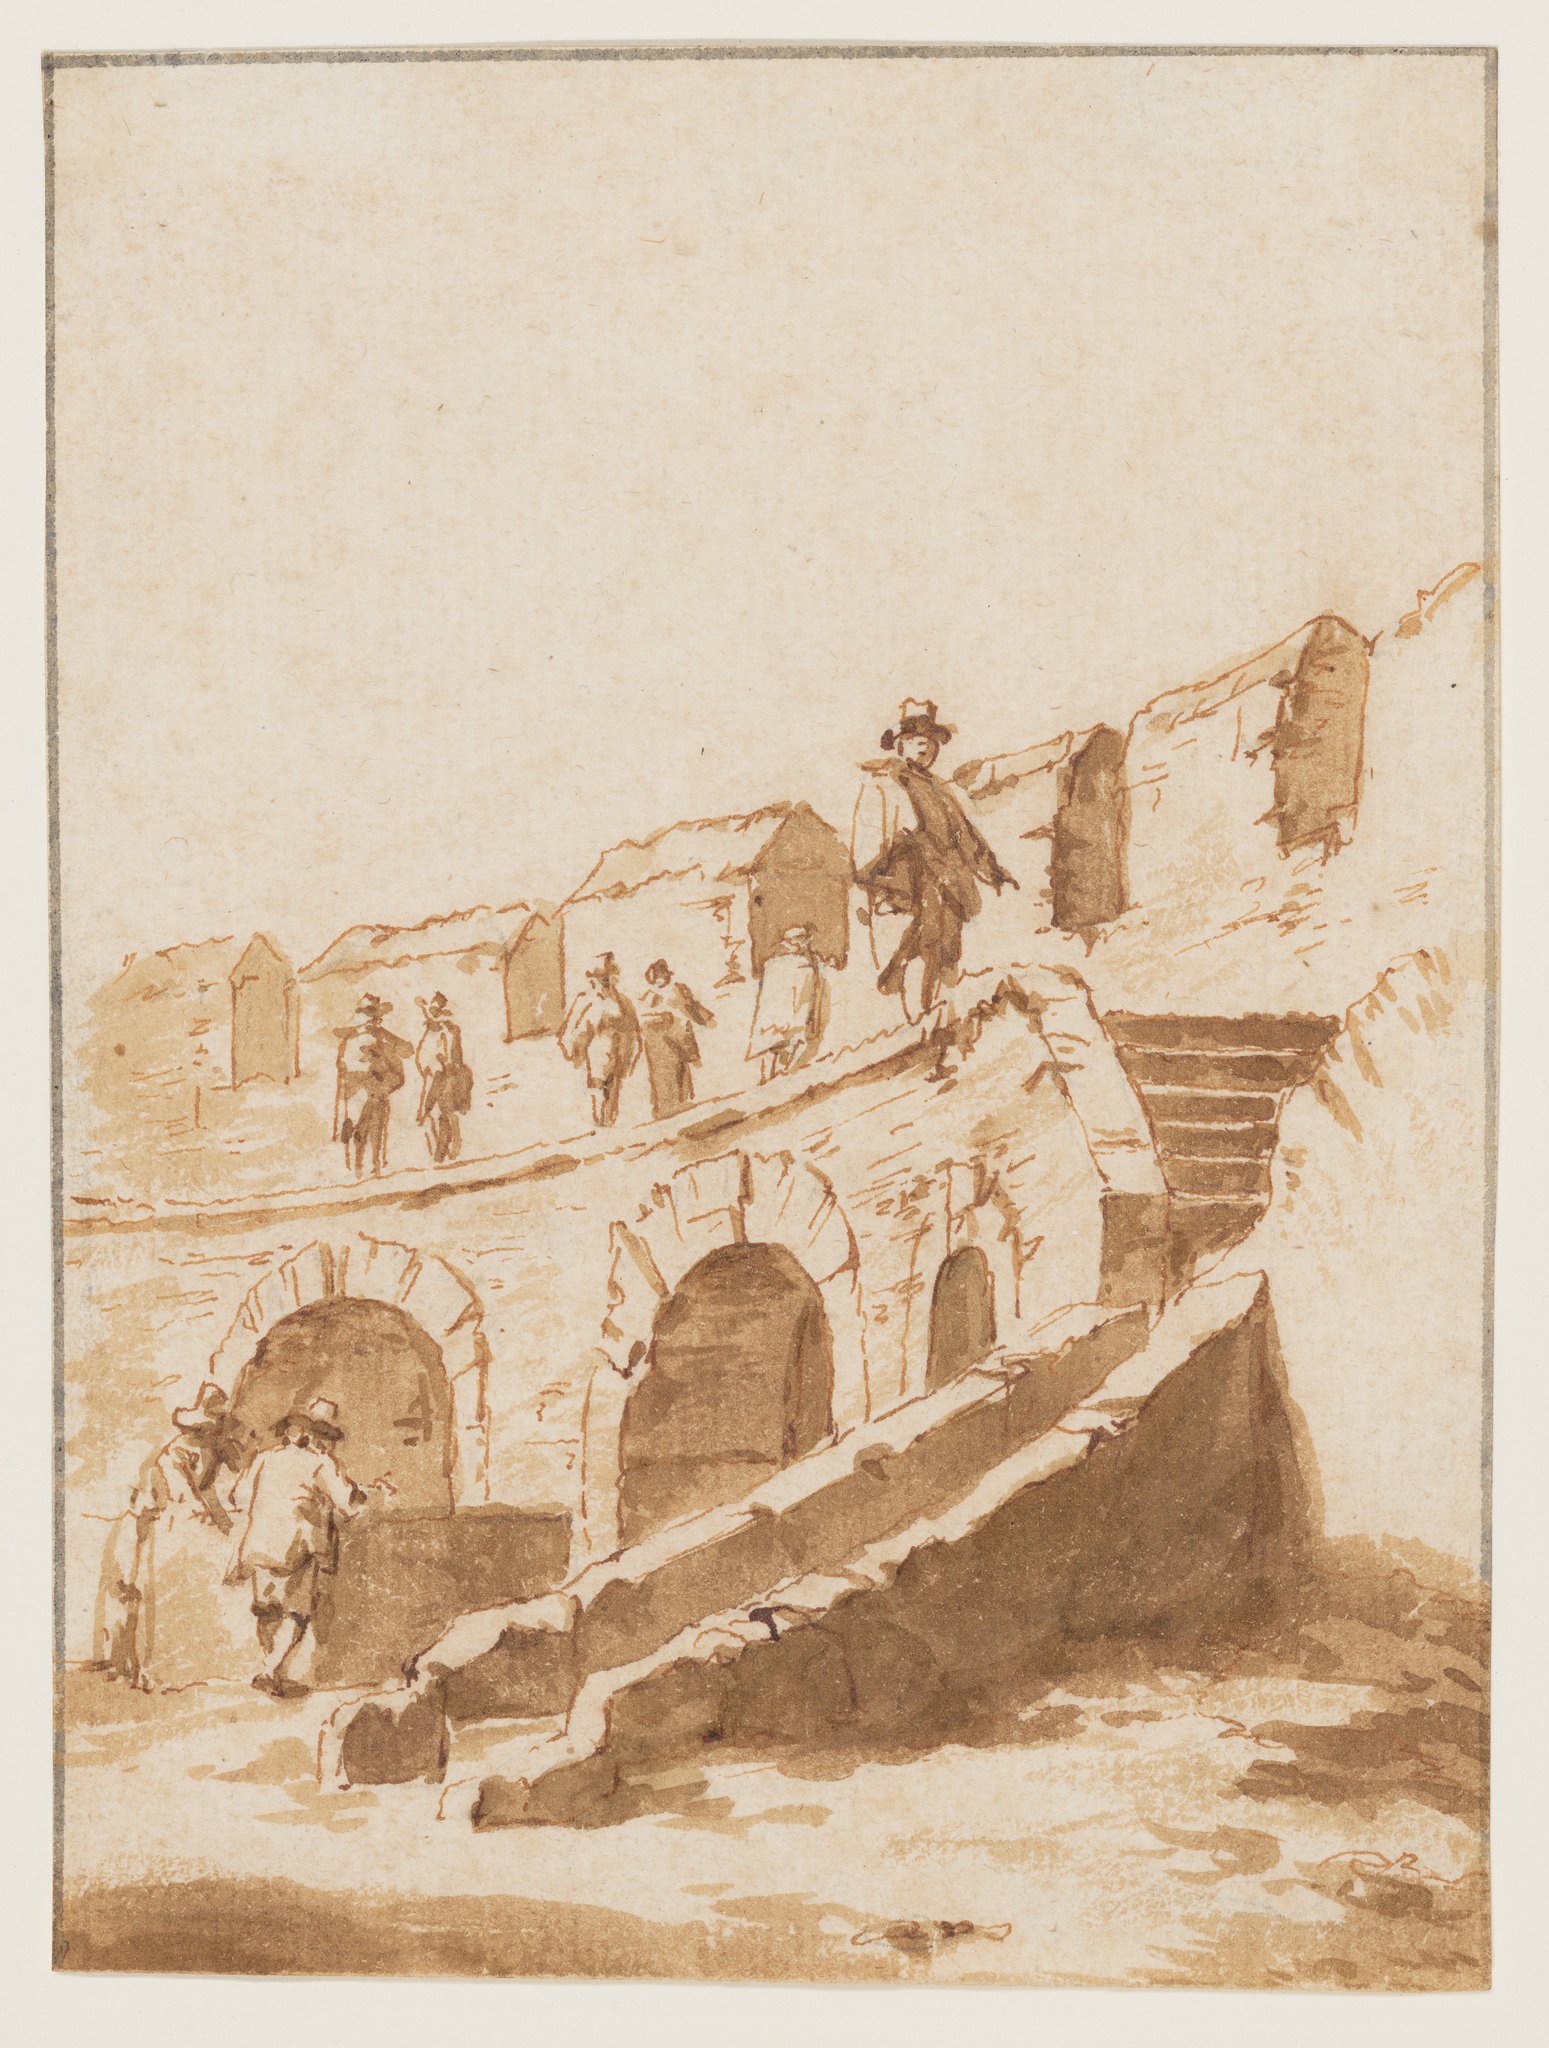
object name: drawing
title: The Burcht in Leiden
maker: jan de bisschop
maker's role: artist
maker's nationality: dutch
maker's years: 1628-1671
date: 1634-1666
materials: ink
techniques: pen, wash